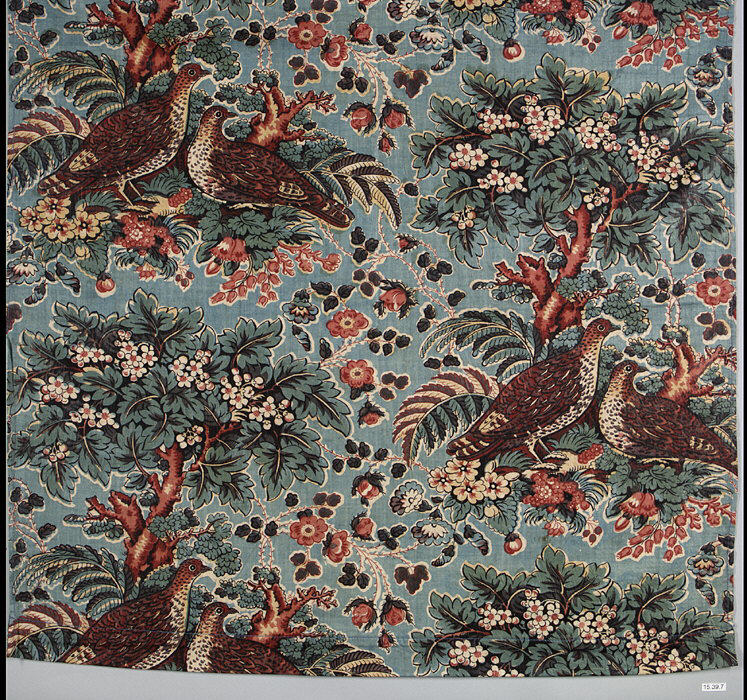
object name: piece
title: Printed textile with game birds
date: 1814-1816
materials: cotton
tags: birds,flowers,trees